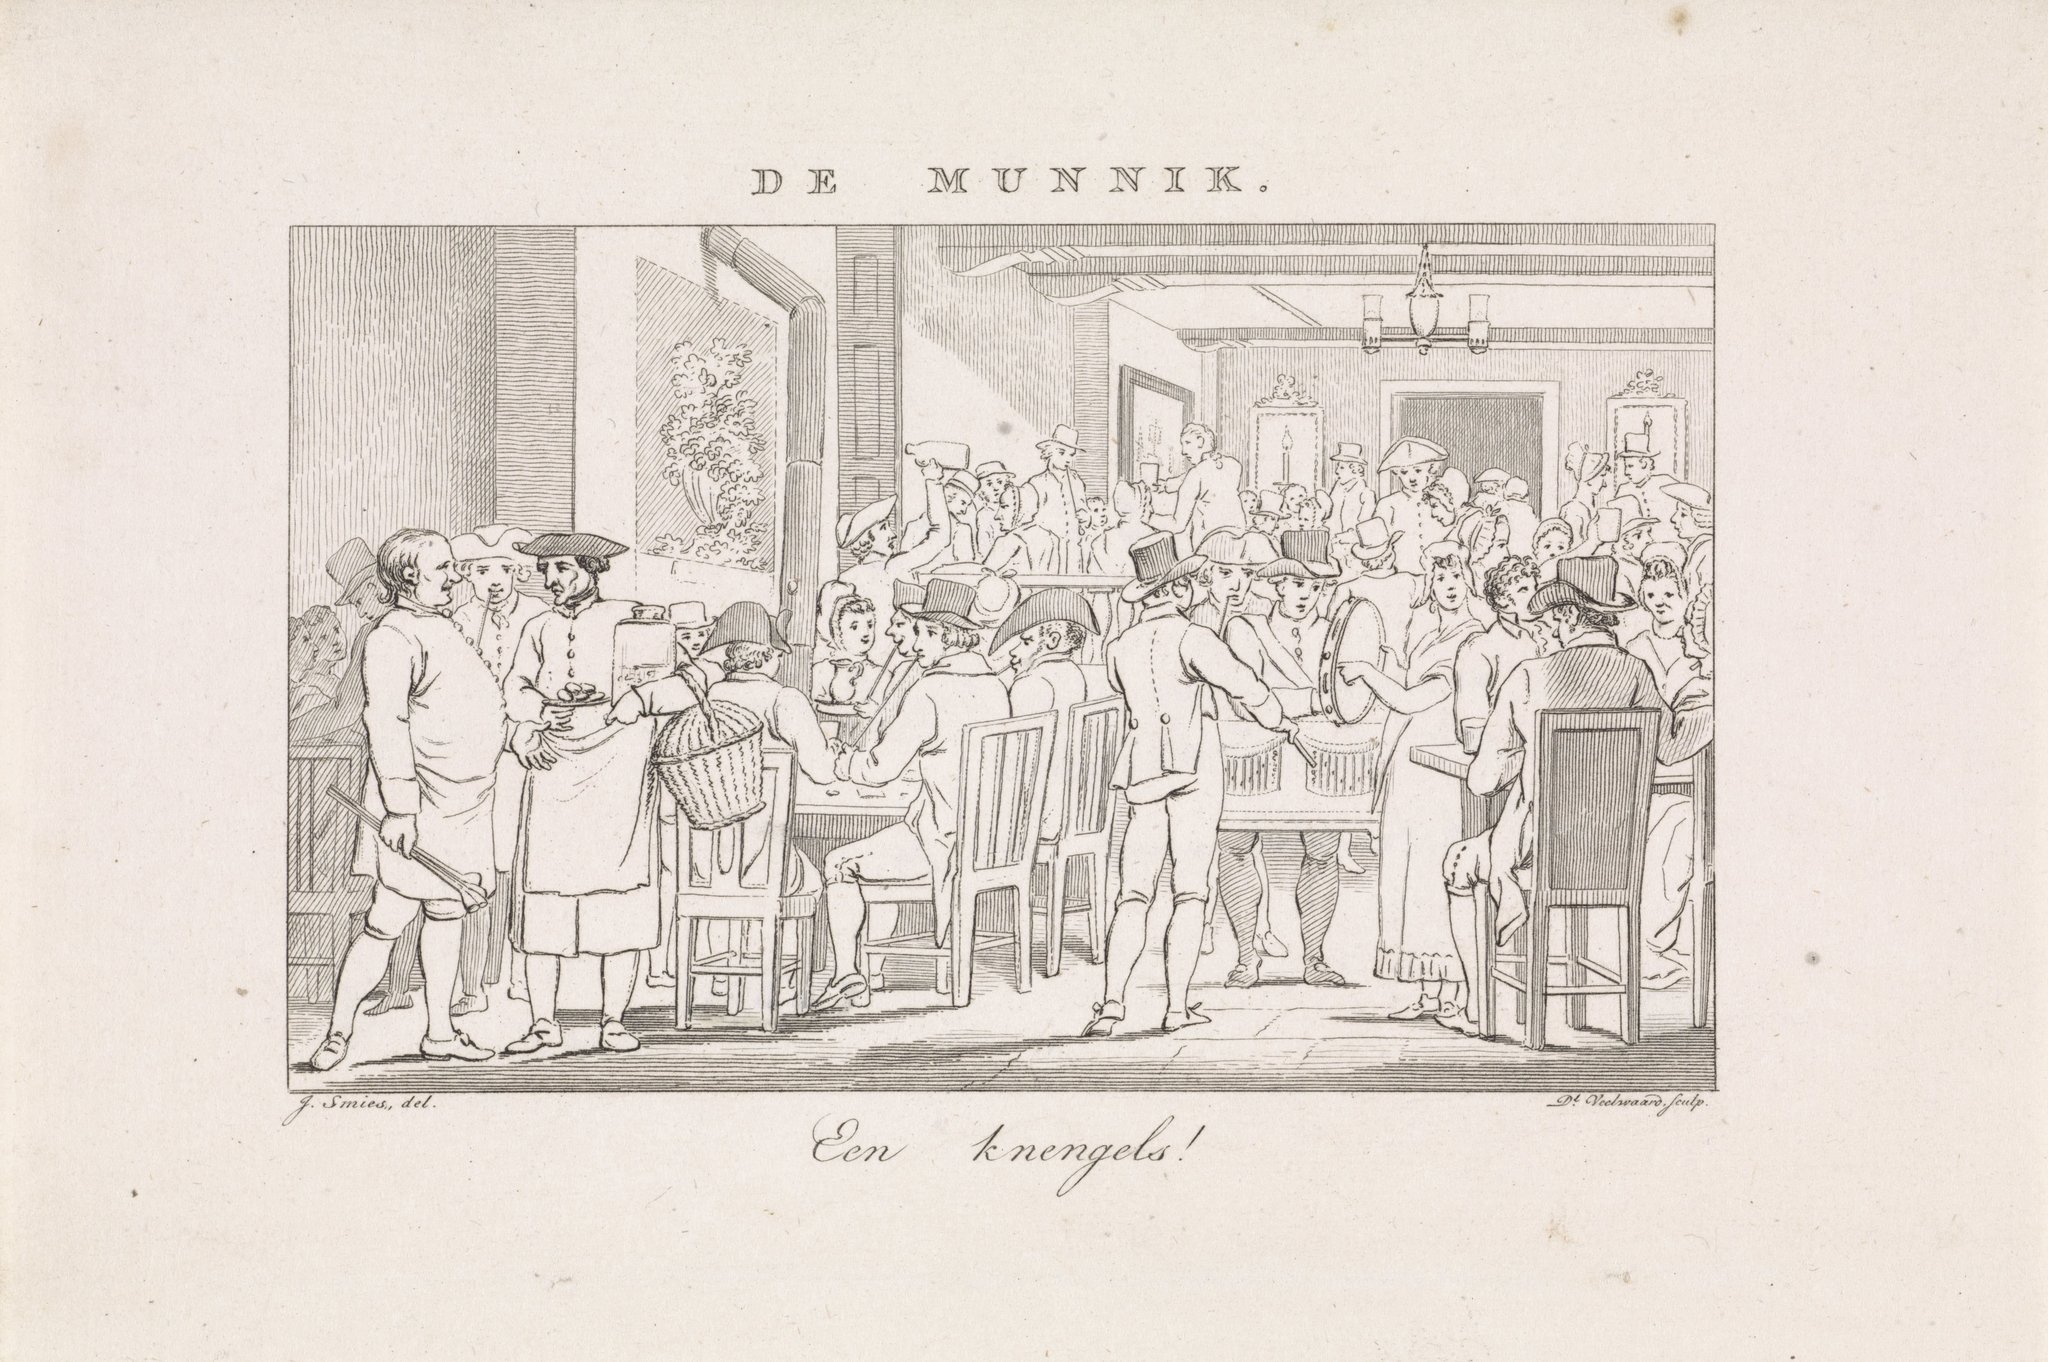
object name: print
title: De Munnik/ Een knengels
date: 1808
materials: paper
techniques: etching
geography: amsterdam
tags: inn, coffee-house, public house, etc.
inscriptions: collector's mark: Lugt 2228, collector's mark: Lugt 2760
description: Vele figuren in het interieur van de herberg De Munnik op de hoek van de Monnikenstraat en de Oudezijds Achterburgwal in Amsterdam, 1808.